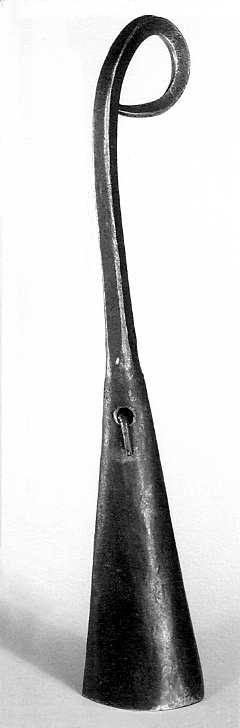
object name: bell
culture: beninese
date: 1867-1900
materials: iron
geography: benin